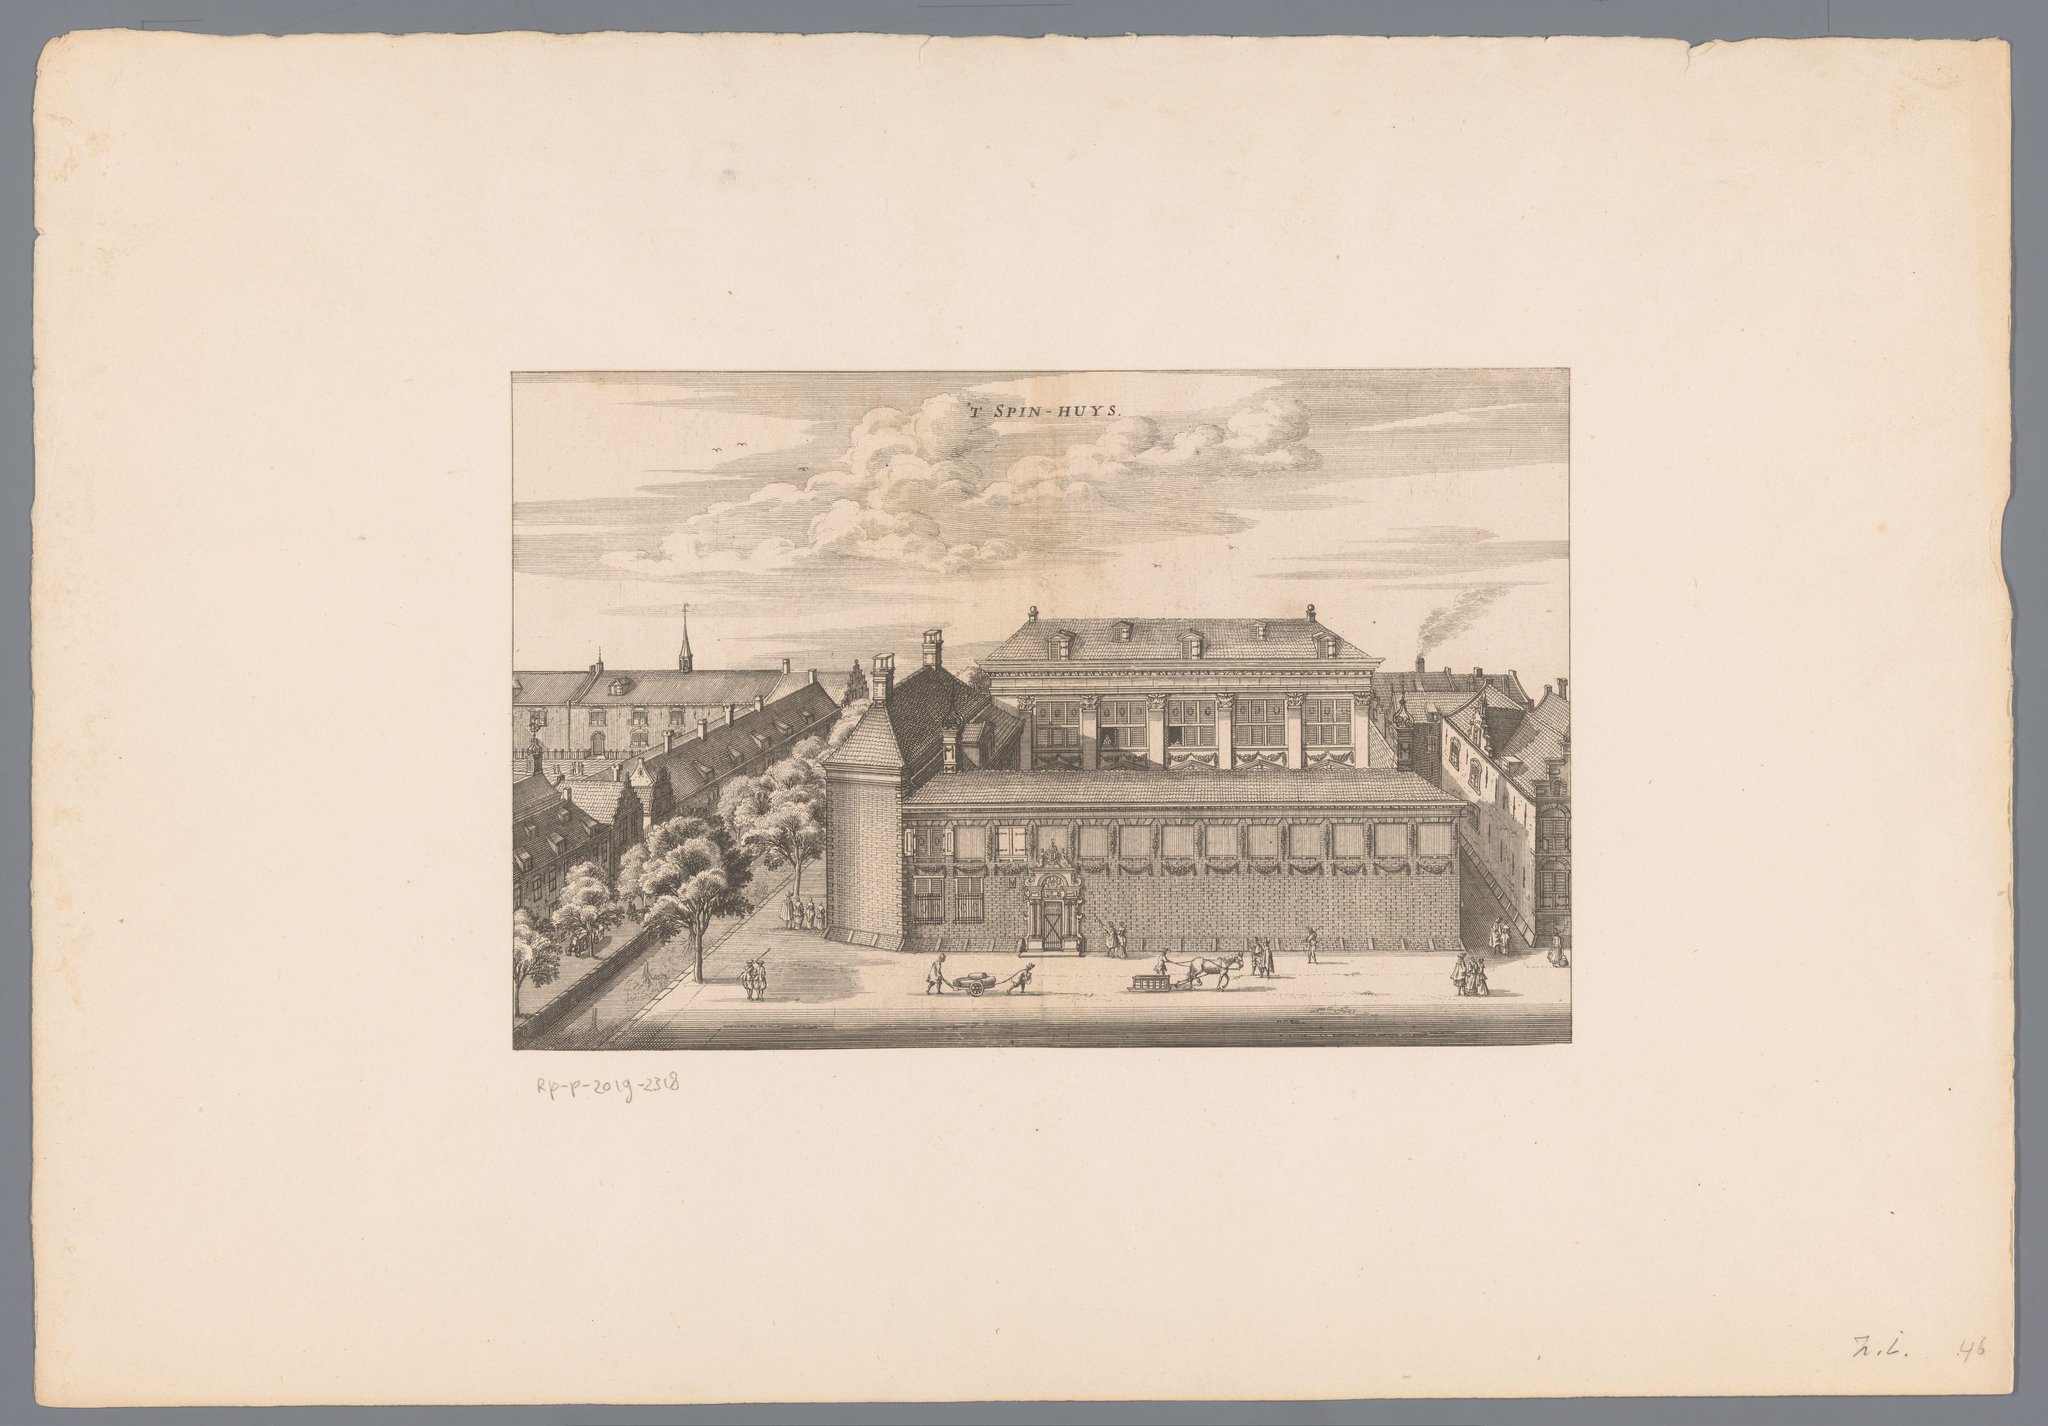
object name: book illustration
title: 'T Spin-Huys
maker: jacob van meurs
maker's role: draughtsman, print maker, publisher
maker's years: 1619-1680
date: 1663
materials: paper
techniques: engraving, etching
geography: amsterdam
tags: prison, jail, workhouse, penal camp, penitentiary, chain gang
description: Prent uit: Dapper, Olfert. Historische beschryving der stadt Amsterdam: waer in de voornaemste geschiedenissen (na een kort verhael van gansch Hollant en d'omleggende dorpen (…). Amsterdam: Jacob van Meurs, 1663, tussen p. 416 en 417. De tweede staat van de prent heeft een toegevoegde Franse titel.